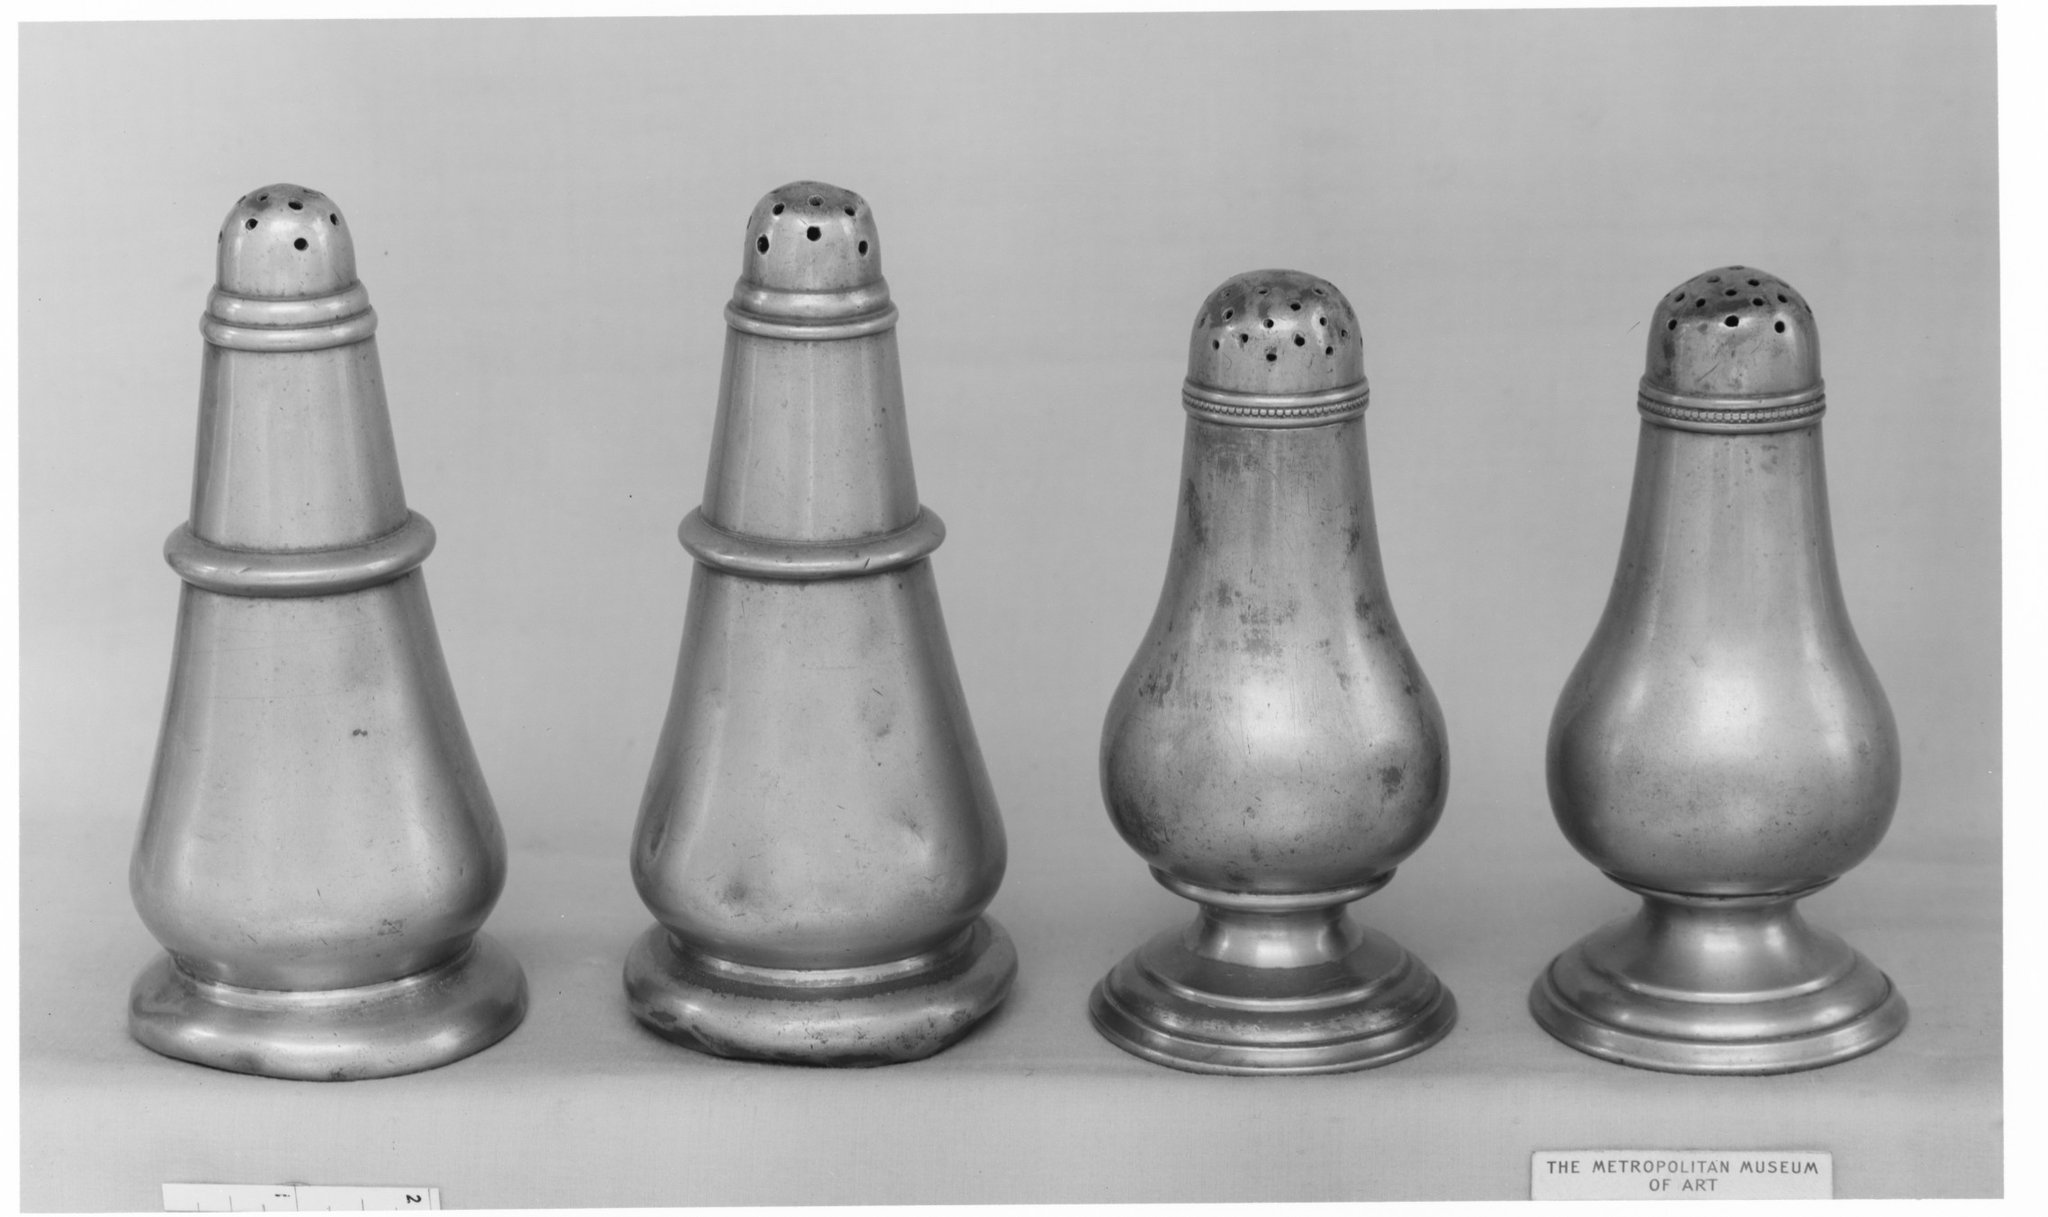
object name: caster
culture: american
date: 1850-1900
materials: pewter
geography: united states